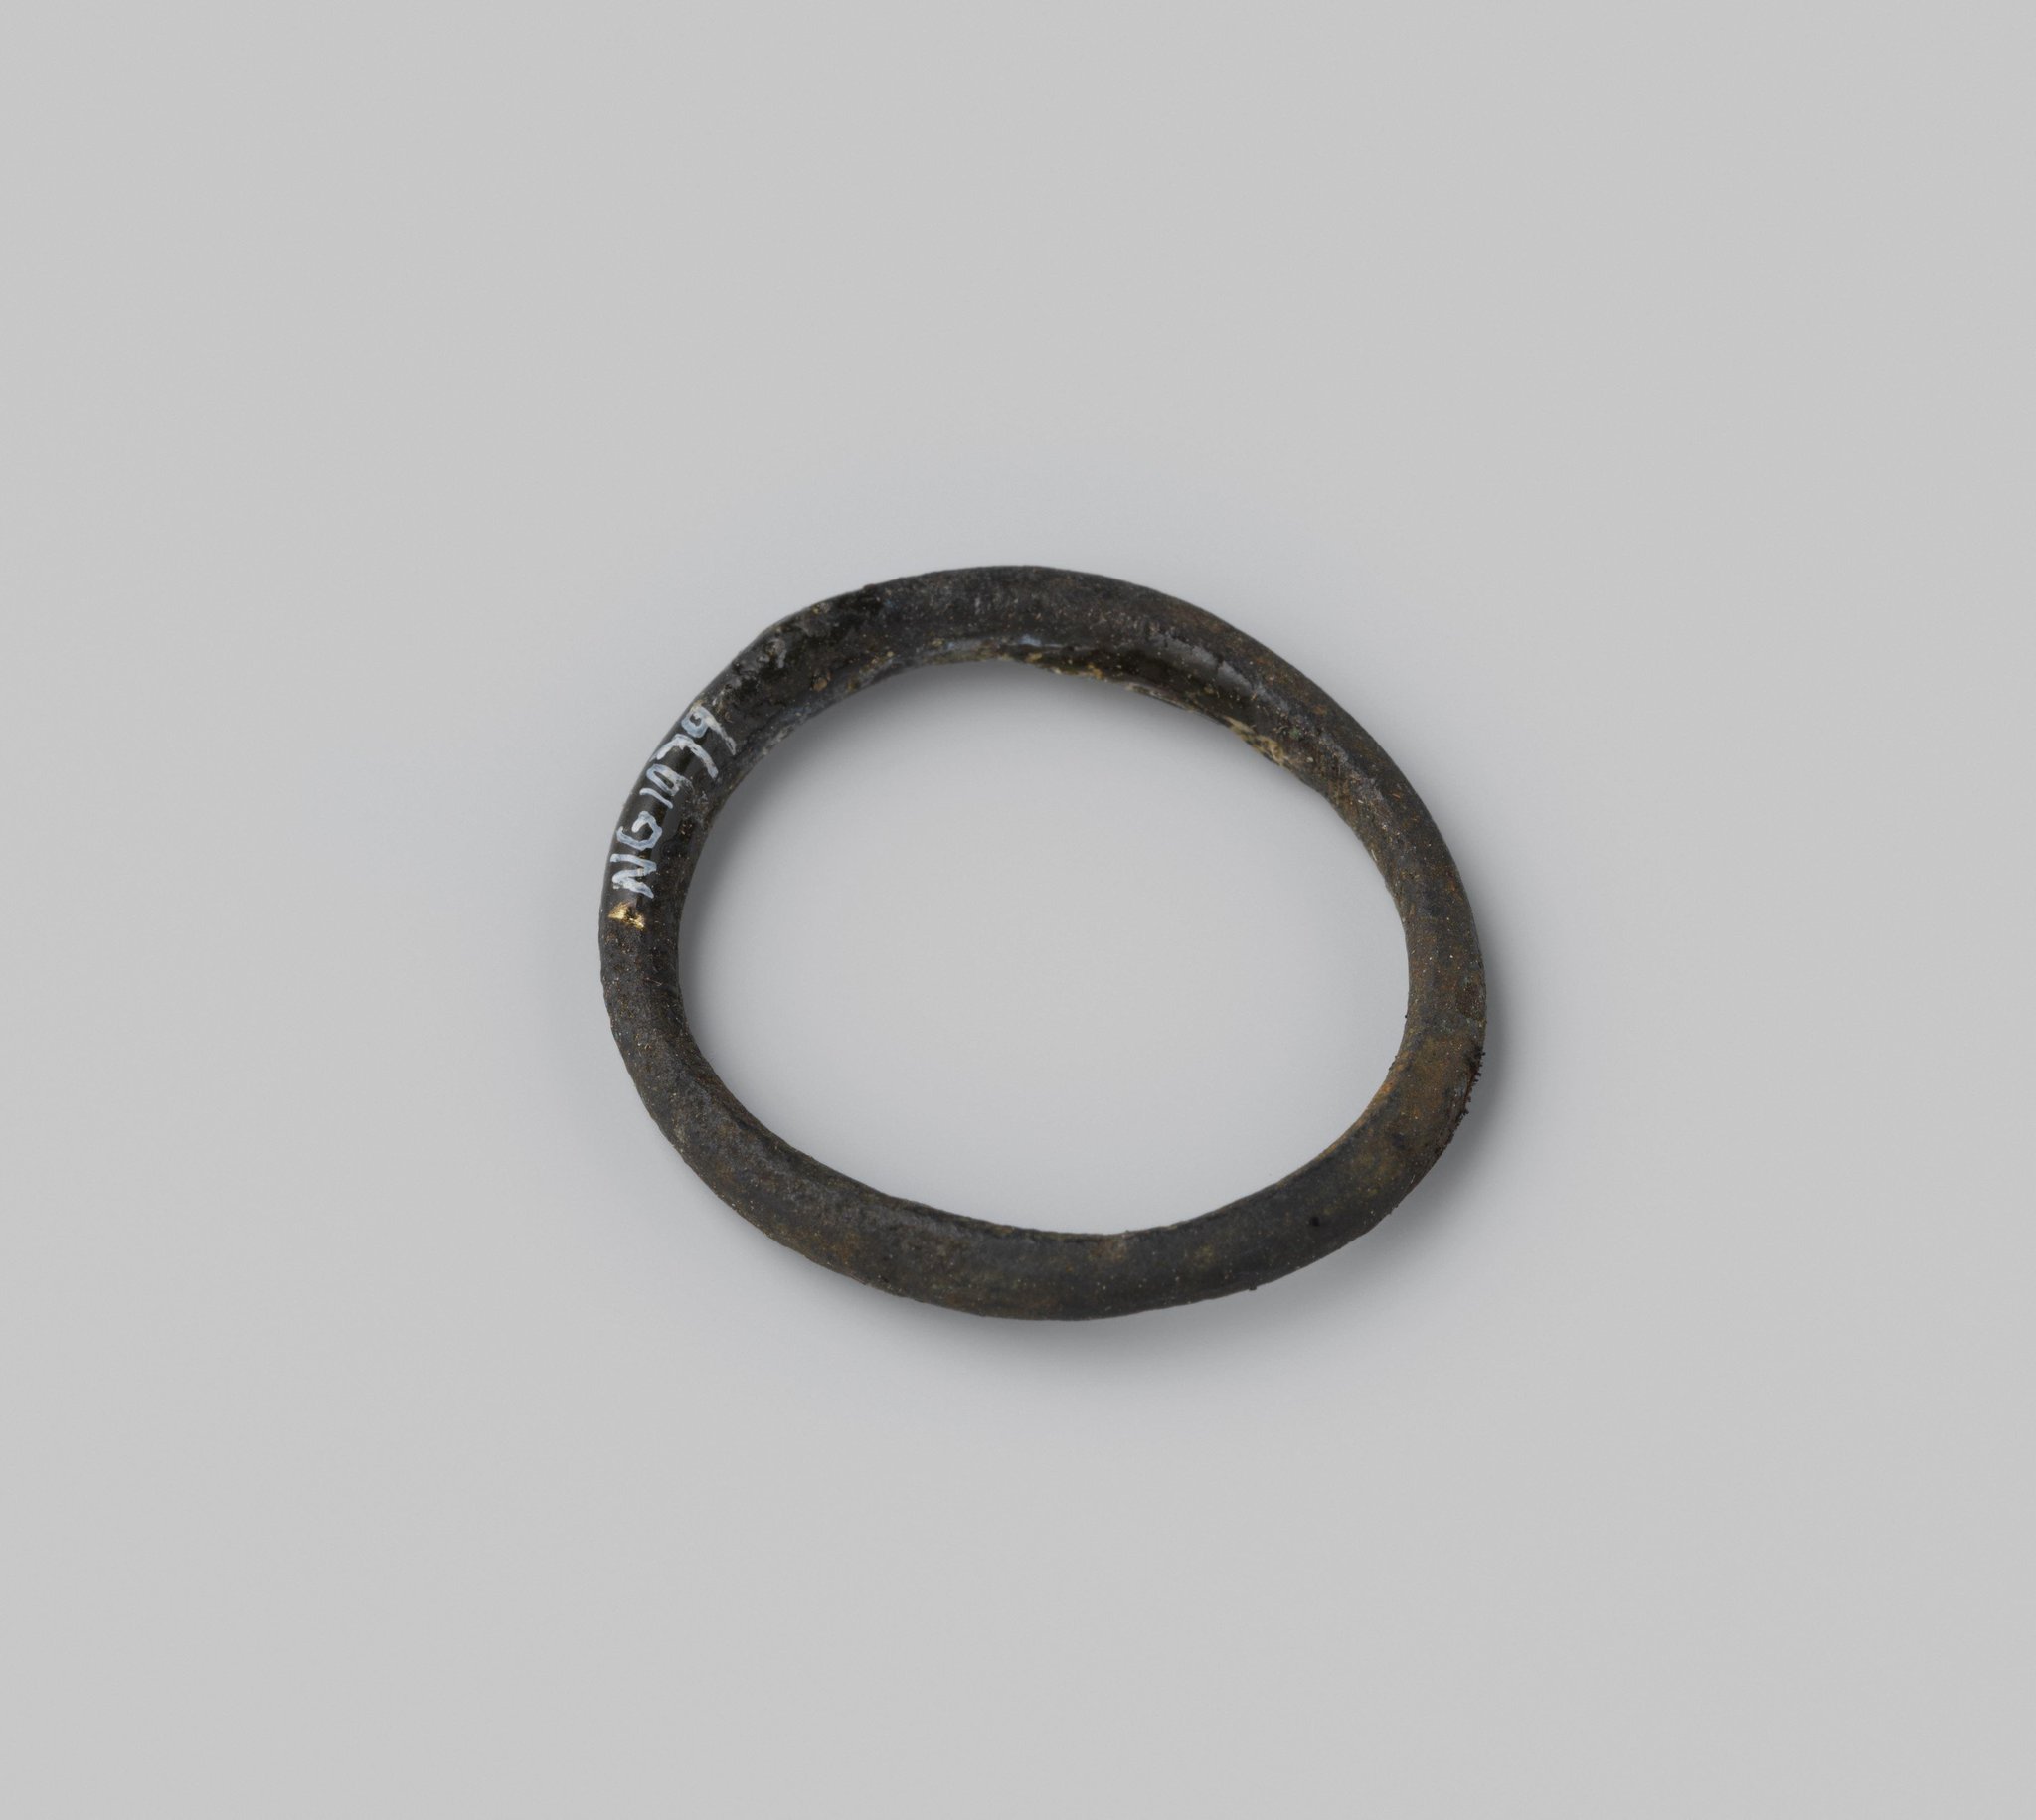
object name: fragment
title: Ringvormig fragment uit het wrak van de Oost-Indiëvaarder Hollandia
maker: Anonymous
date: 1700-1743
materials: copper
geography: netherlands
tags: verenigde oostindische compagnie, hollandia (schip), annet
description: Varied parts or fragments, rings or ring-shaped fragments; 80H704.